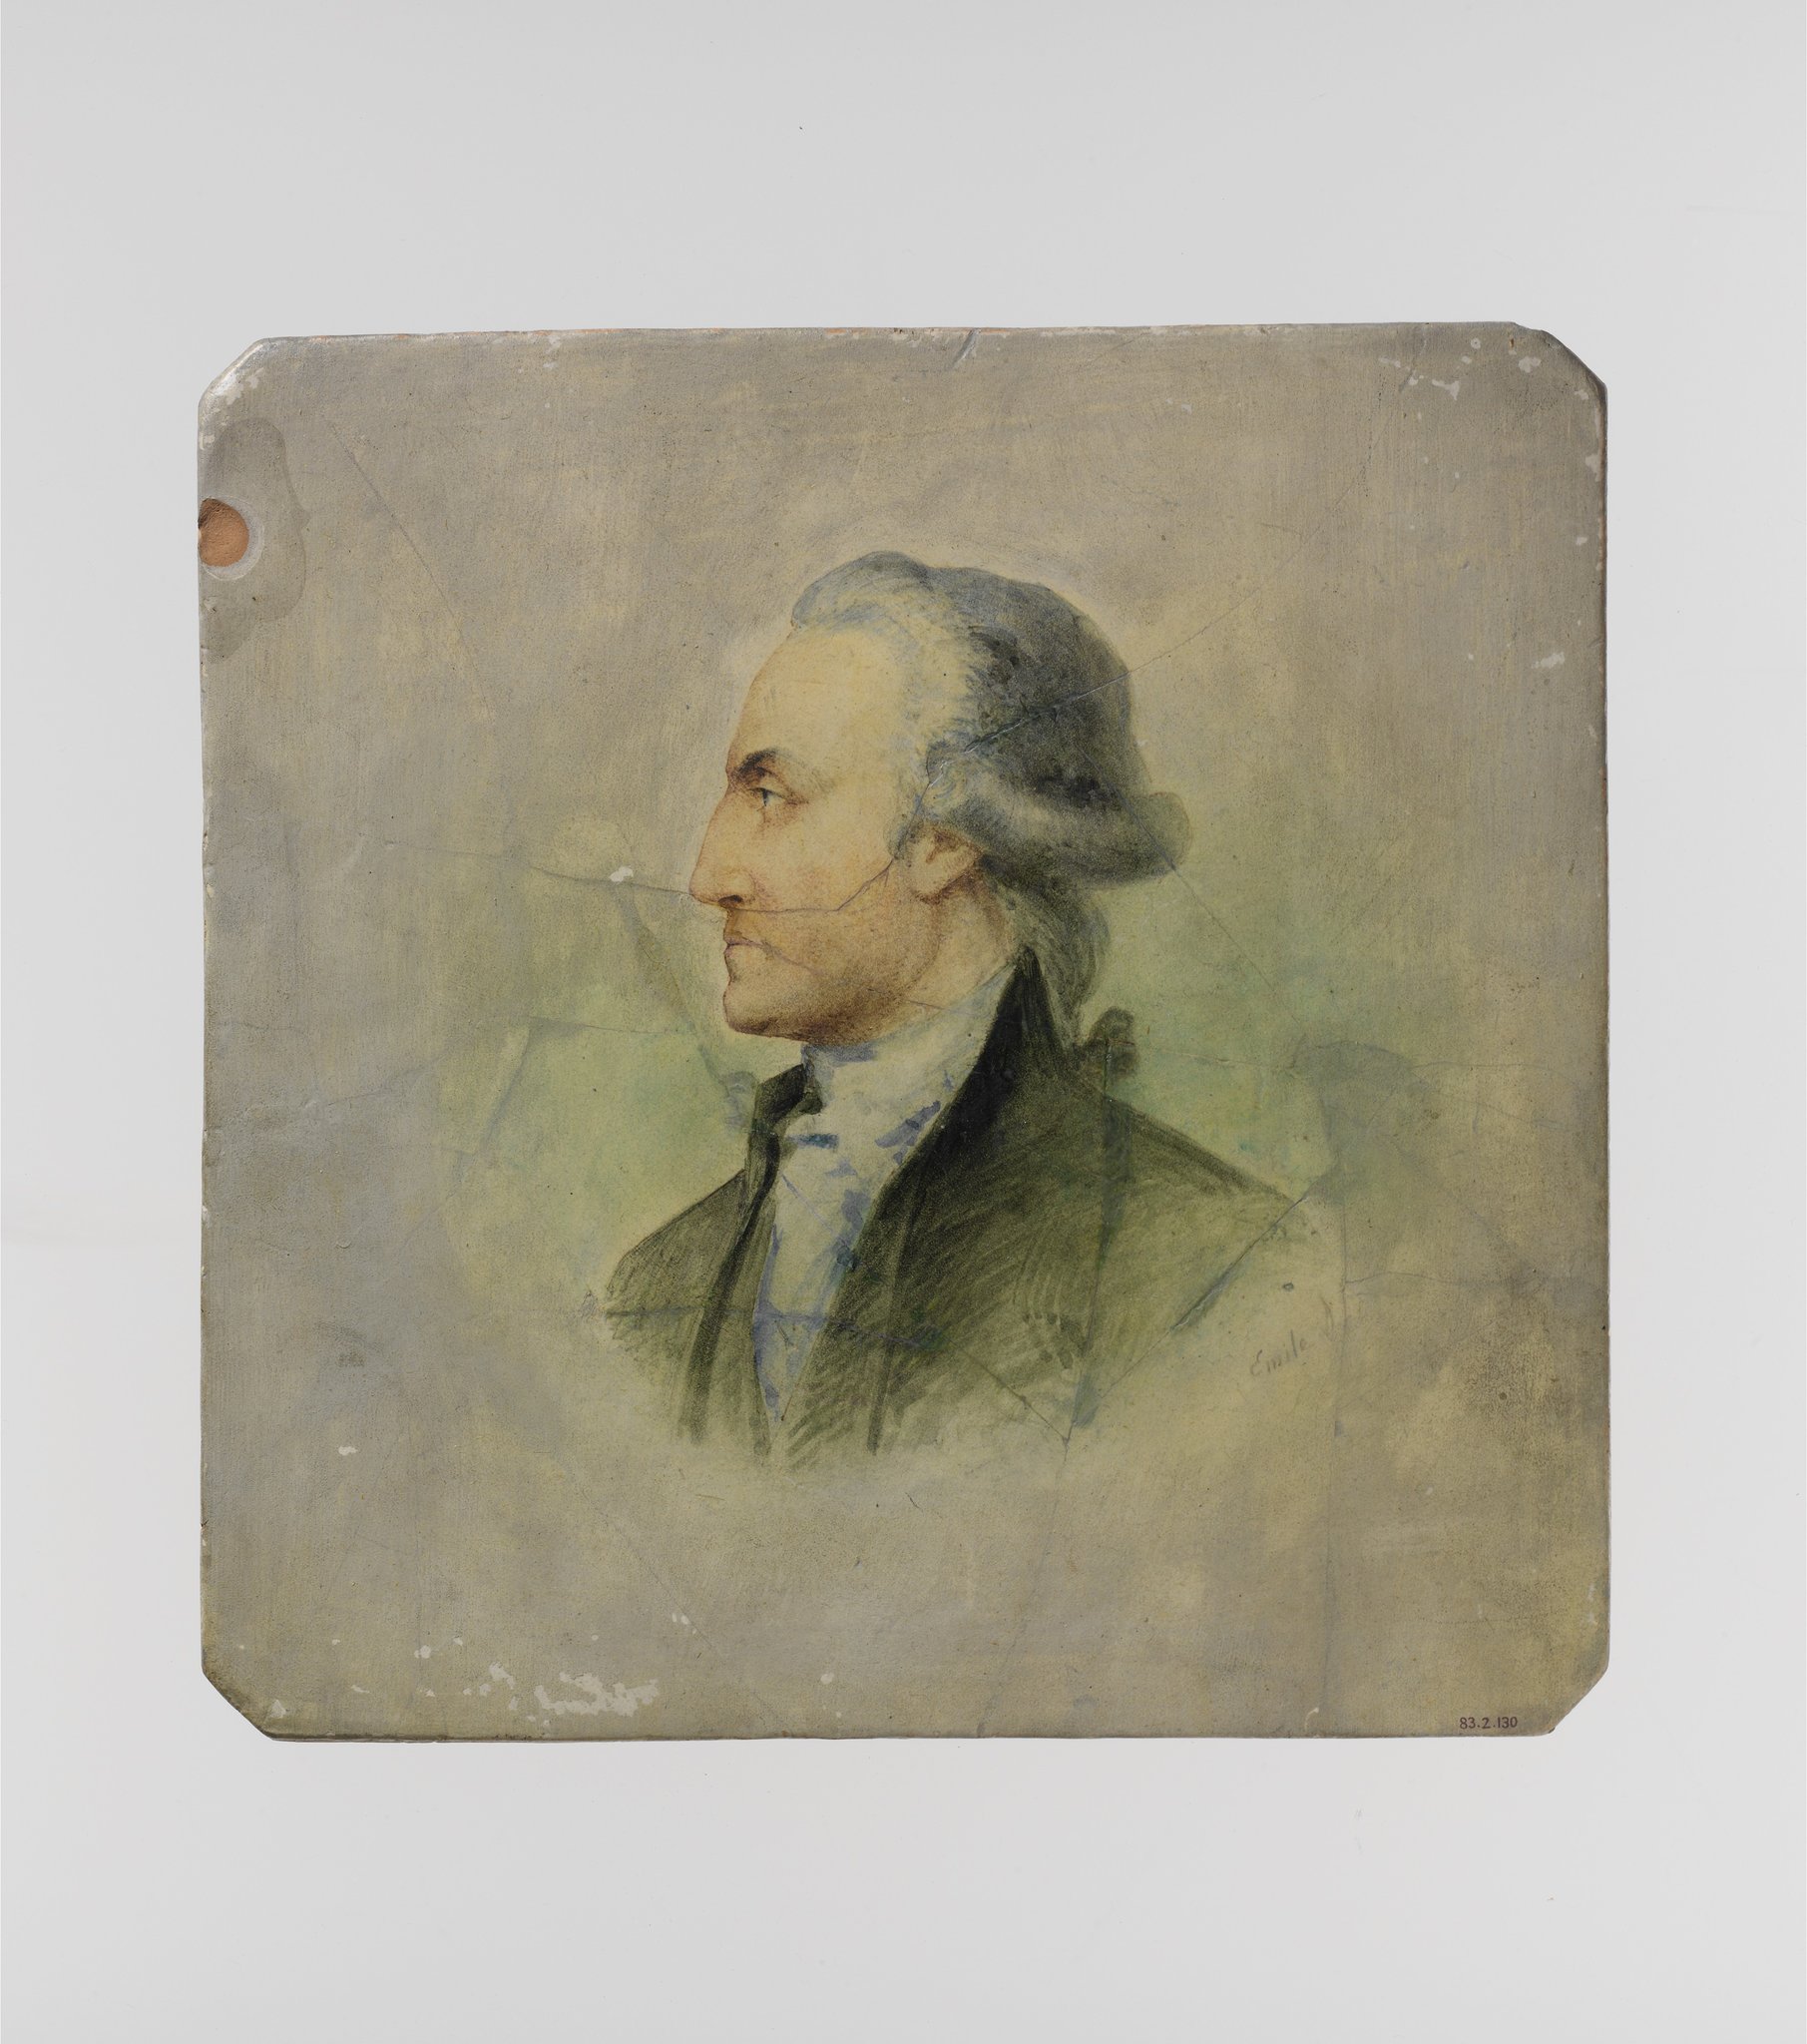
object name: plaque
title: George Washington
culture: french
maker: emile dupont-zipcy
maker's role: artist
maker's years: 1822-1885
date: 1840-1883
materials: faience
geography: france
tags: george washington,men,portraits,profiles